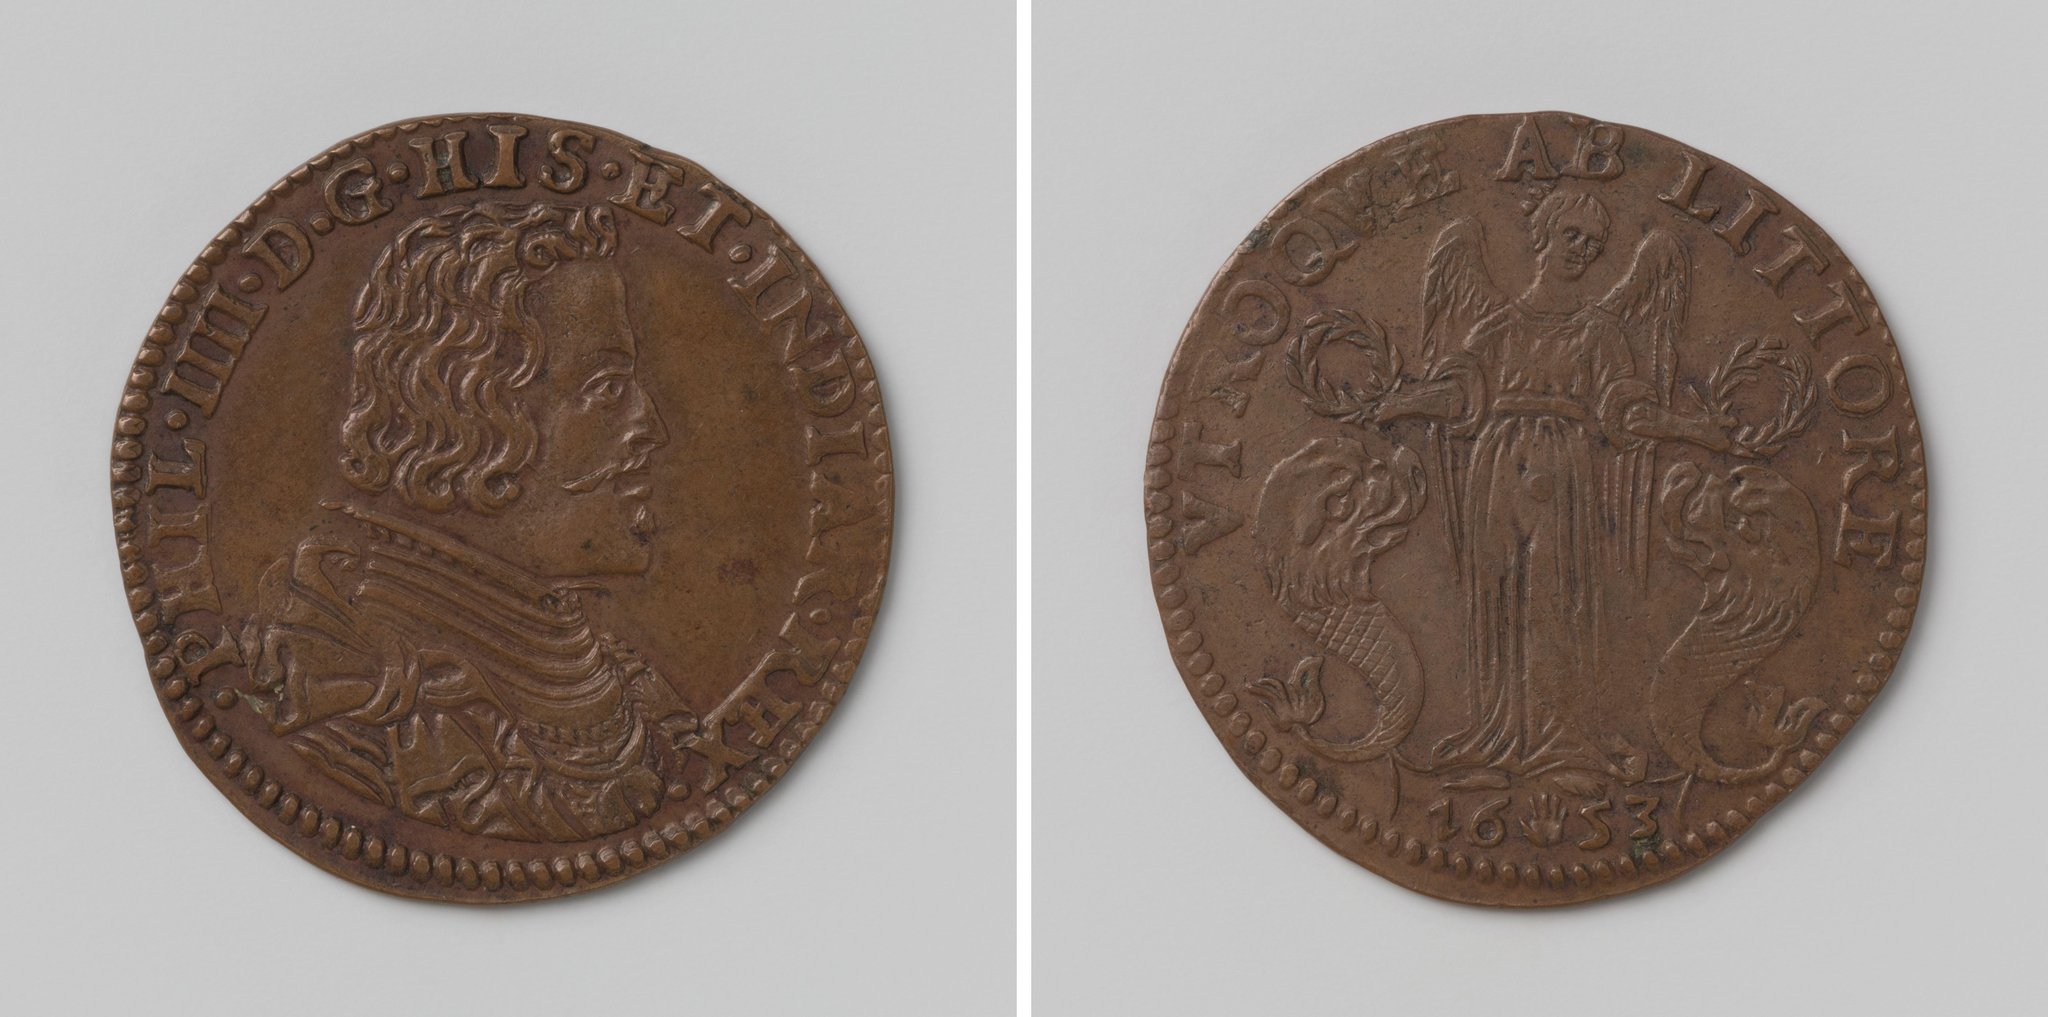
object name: jeton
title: Inname van Duinkerken en Barcelona, rekenpenning geslagen ter ere van Filips IV, koning van Spanje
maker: Anonymous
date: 1652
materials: copper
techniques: striking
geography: antwerp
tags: filips iv (koning van spanje)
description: Koperen penning. Voorzijde: borststuk man binnen omschrift. Keerzijde: gevleugelde Overwinning kroont de beide dolfijnen die haar flankeren binnen omschrift boven jaartal in cartouche